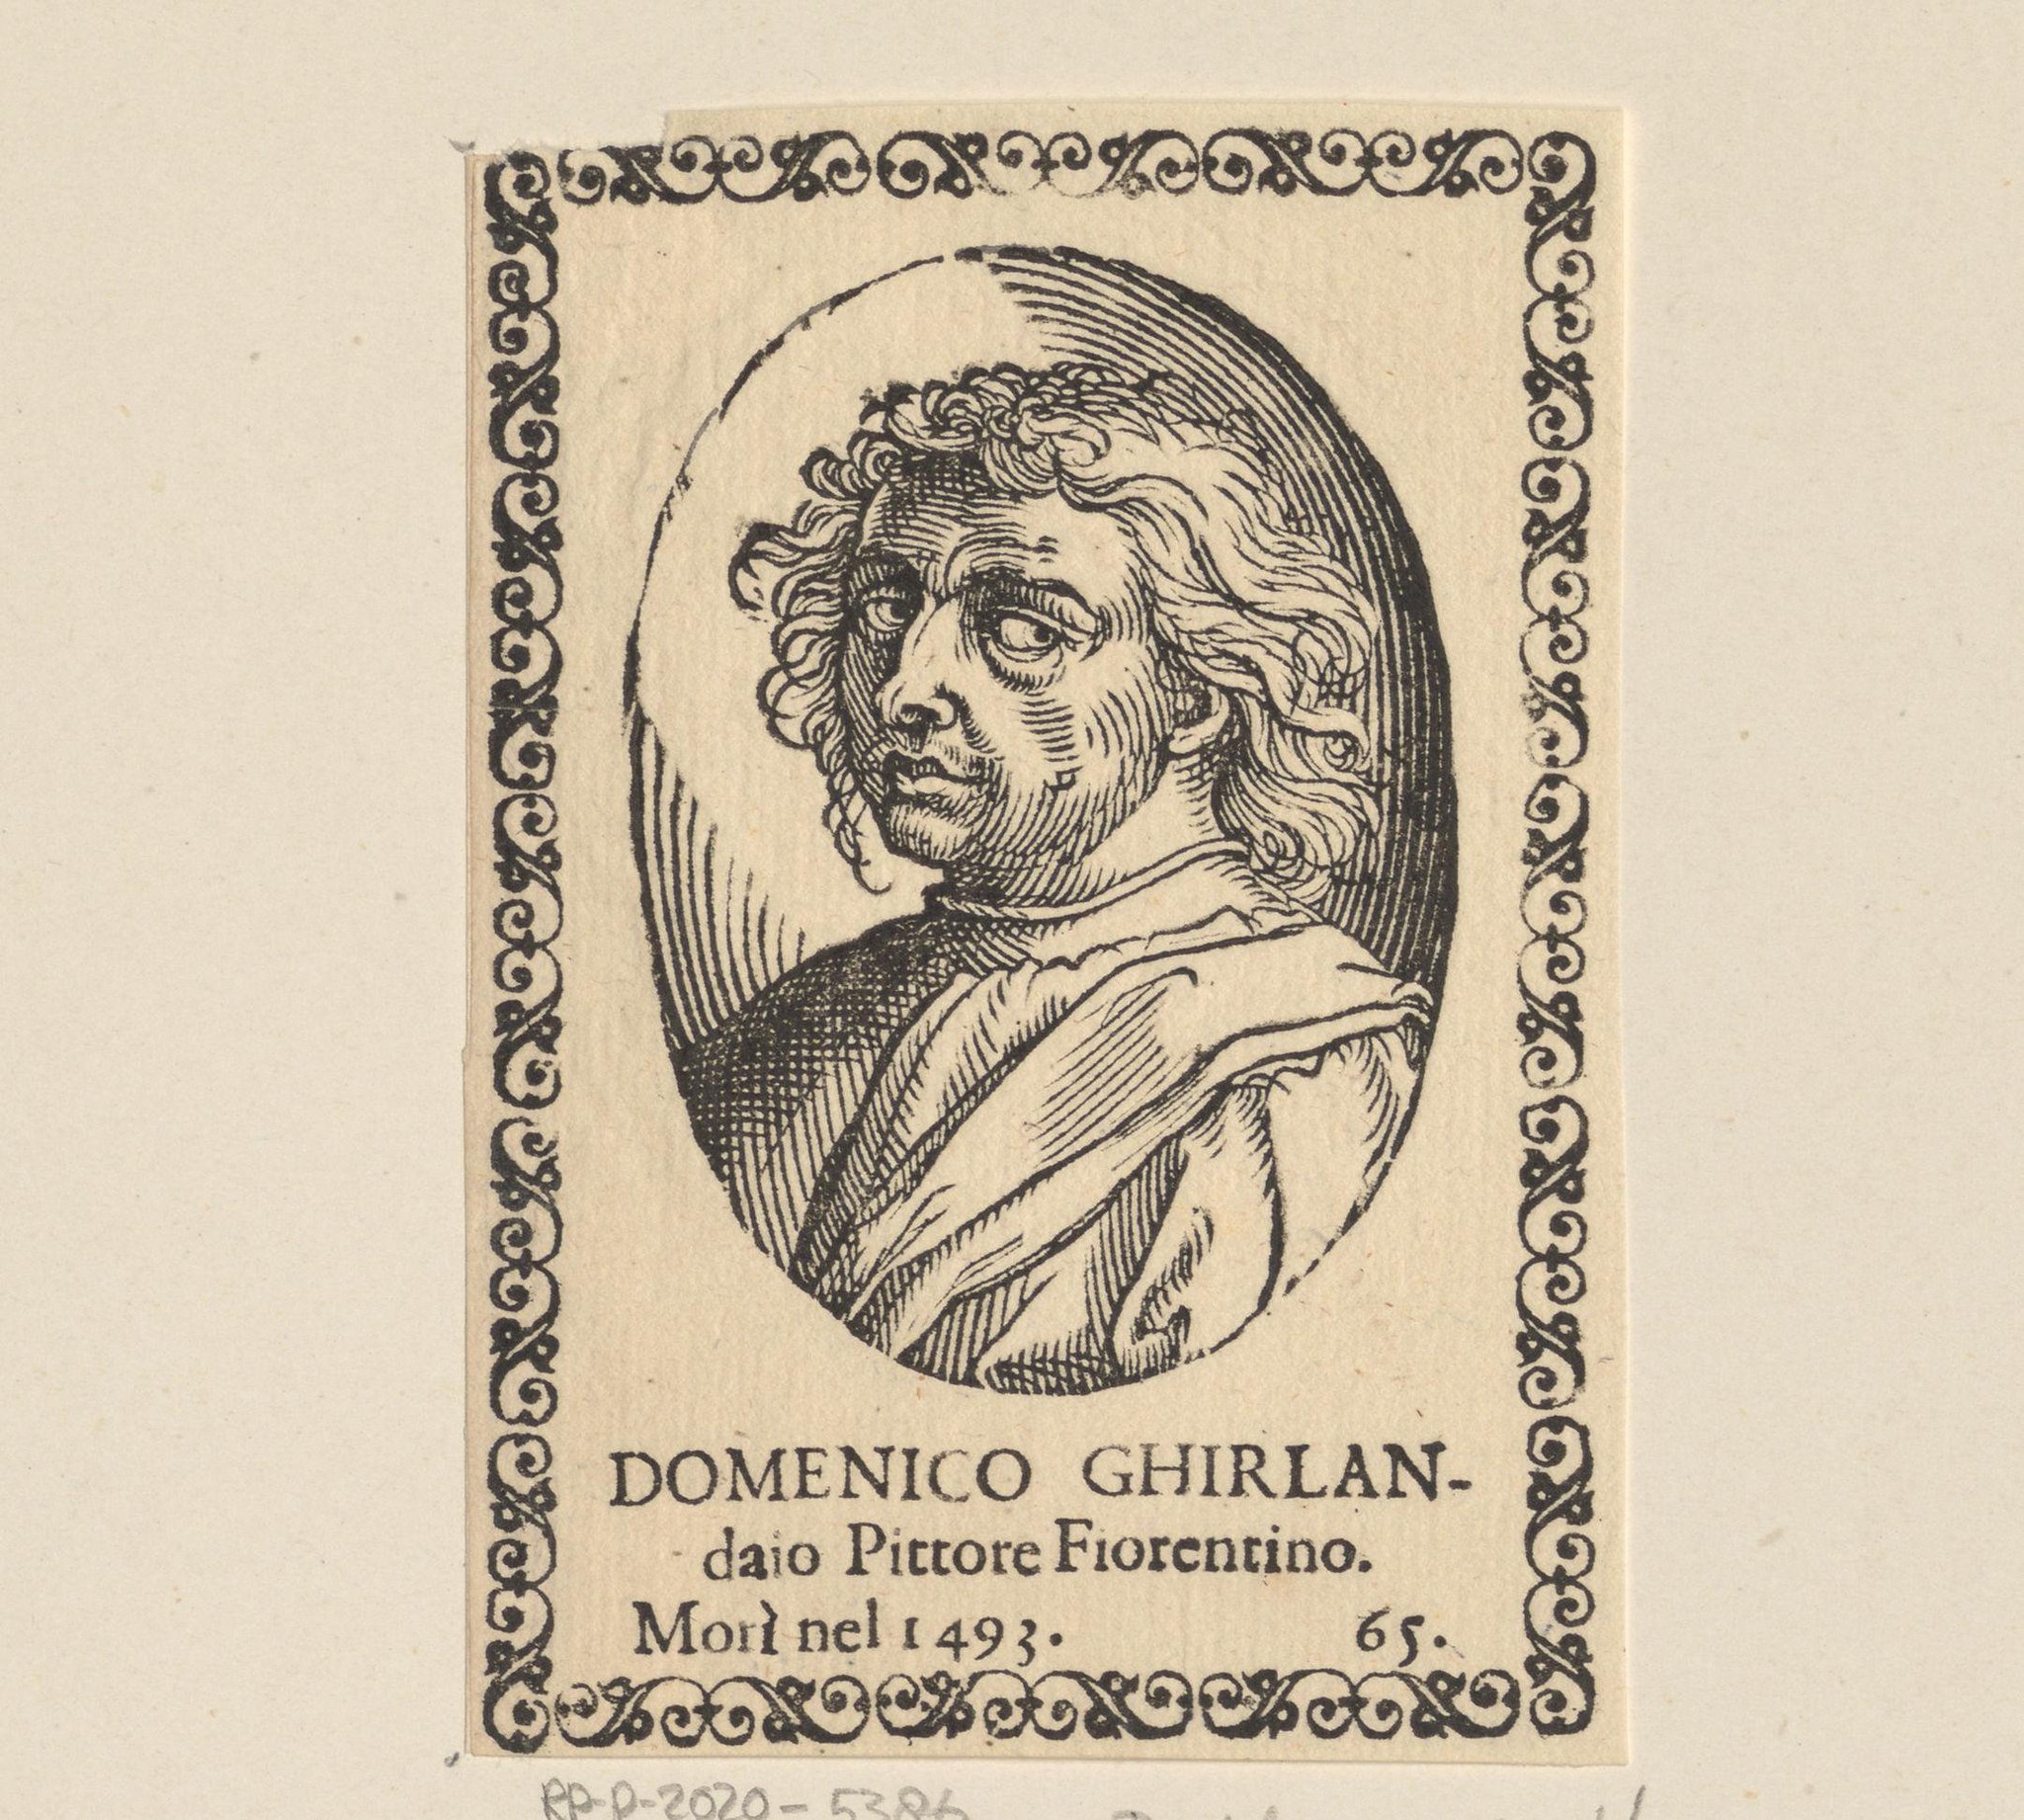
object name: print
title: Portret van Domenico Ghirlandaio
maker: Anonymous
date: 1568-1650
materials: paper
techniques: letterpress printing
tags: draughtsman, domenico ghirlandaio, historical persons, portrait, self-portrait of painter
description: Prent uit een onbekende editie van: Vasari, Giorgio. Le Vite de' più eccellenti pittori, scultori, e architettori da Cimabue insino a' tempi nostri. S.l.s.n., [1568]. De prent is met een andere omlijsting gebruikt in de editie uit 1568, en mogelijk in de editie uit 1647.